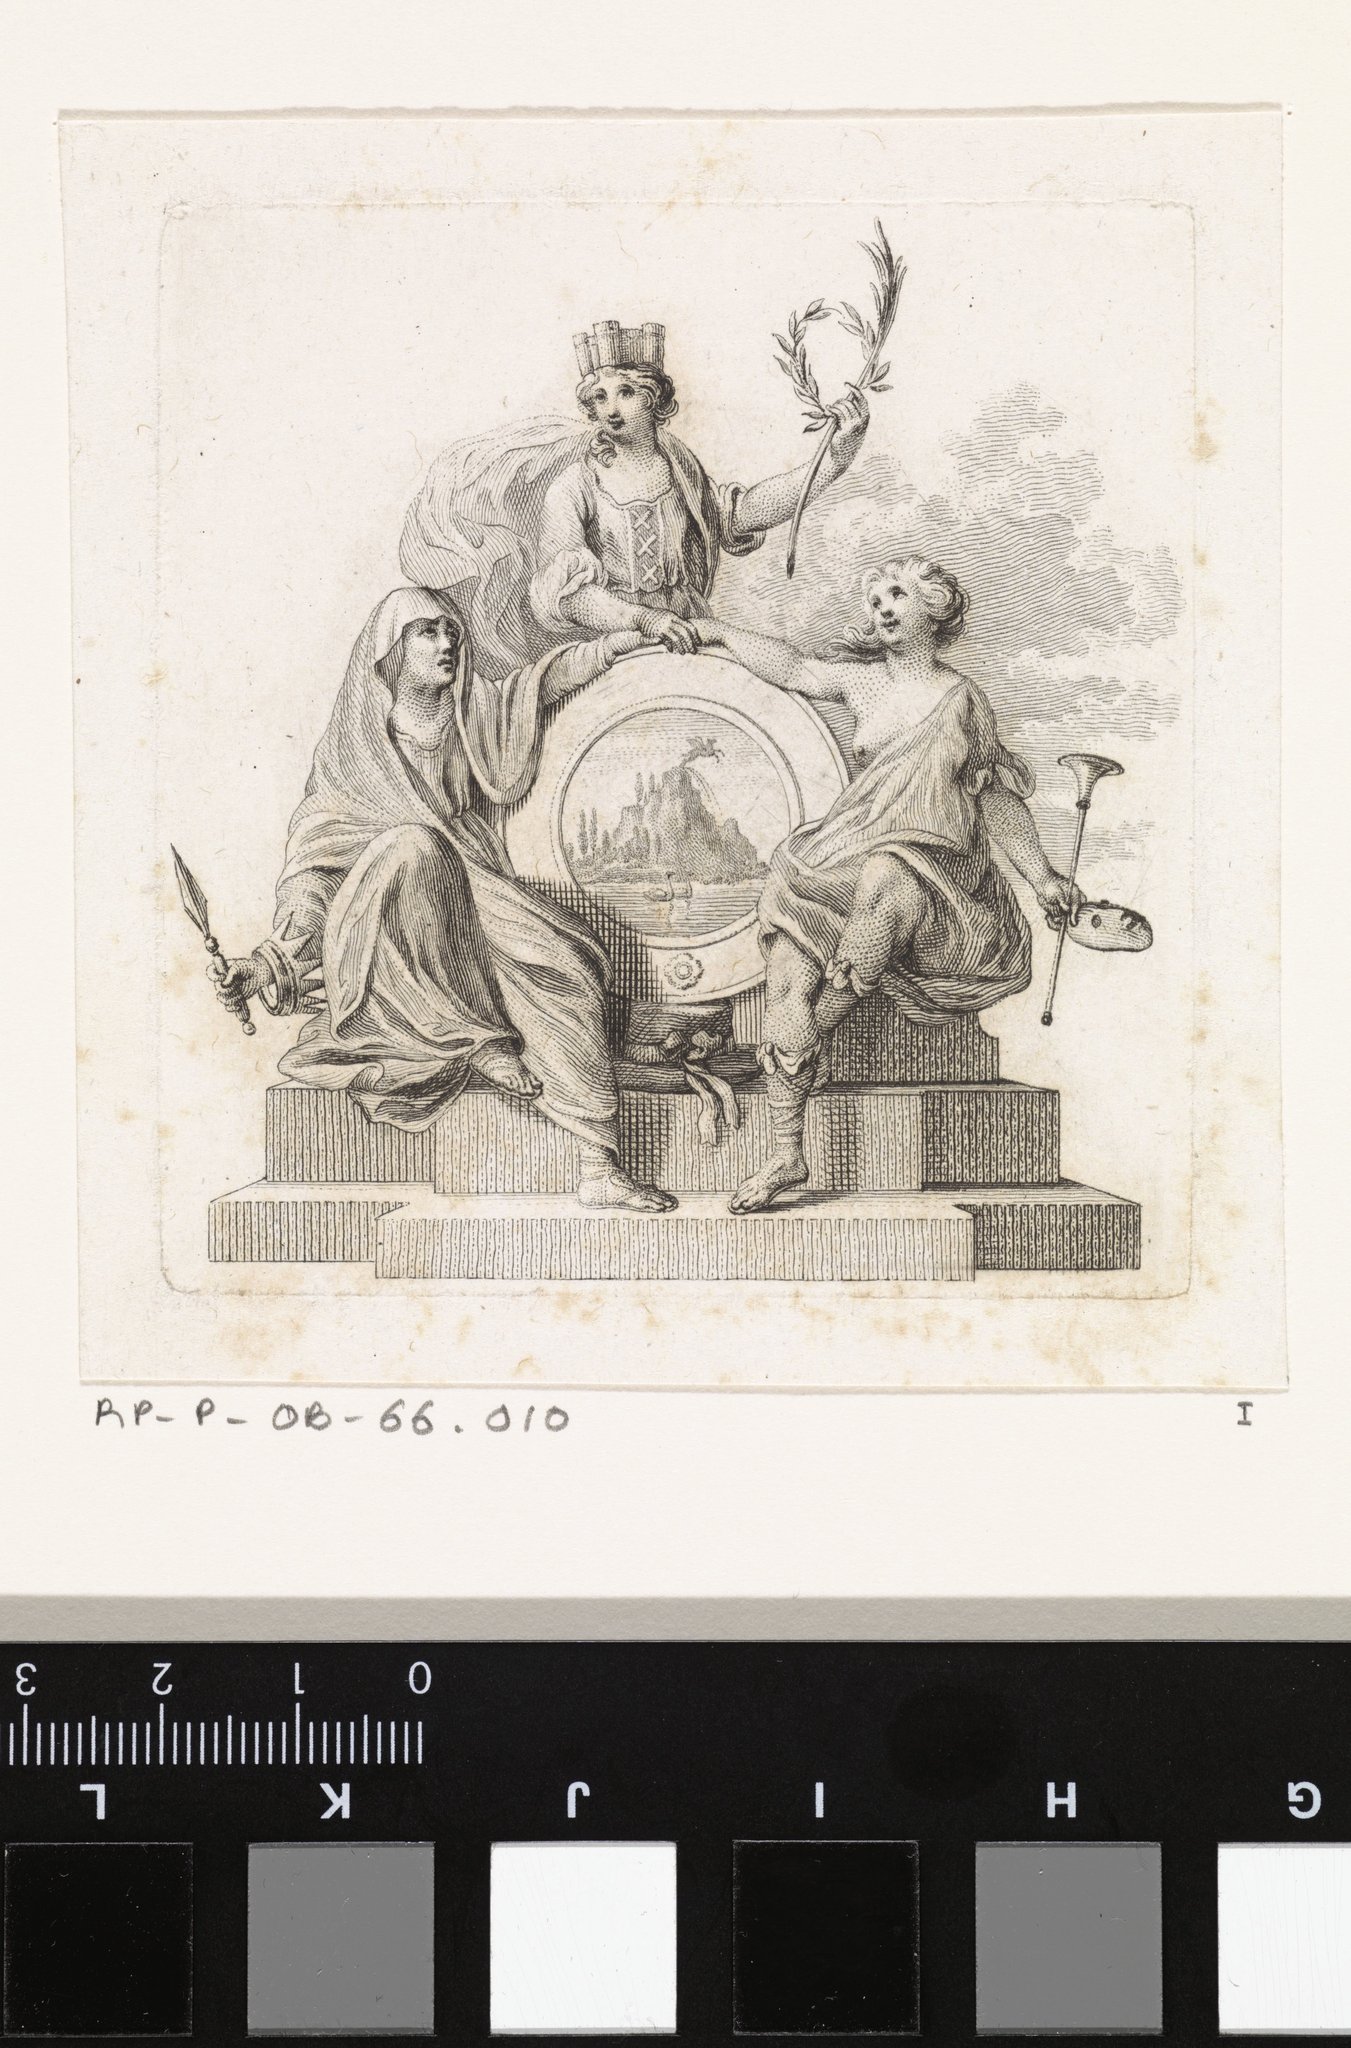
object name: print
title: Allegorische figuren bij een medaillon voor de nationale schouwburg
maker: reinier vinkeles (i)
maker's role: draughtsman, print maker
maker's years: 1741-1816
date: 1751-1816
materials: paper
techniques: engraving, etching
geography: amsterdam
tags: mask, crown (symbol of sovereignty), cities represented allegorically or symbolically, amsterdam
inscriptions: collector's mark: Lugt 240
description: Op een trap zitten drie allegorische figuren bij een medaillon voor de nationale schouwburg. In het midden de stedenmaagd van Amsterdam en naast haar twee vrouwen met attributen zoals een kroon, een bazuin en een masker.